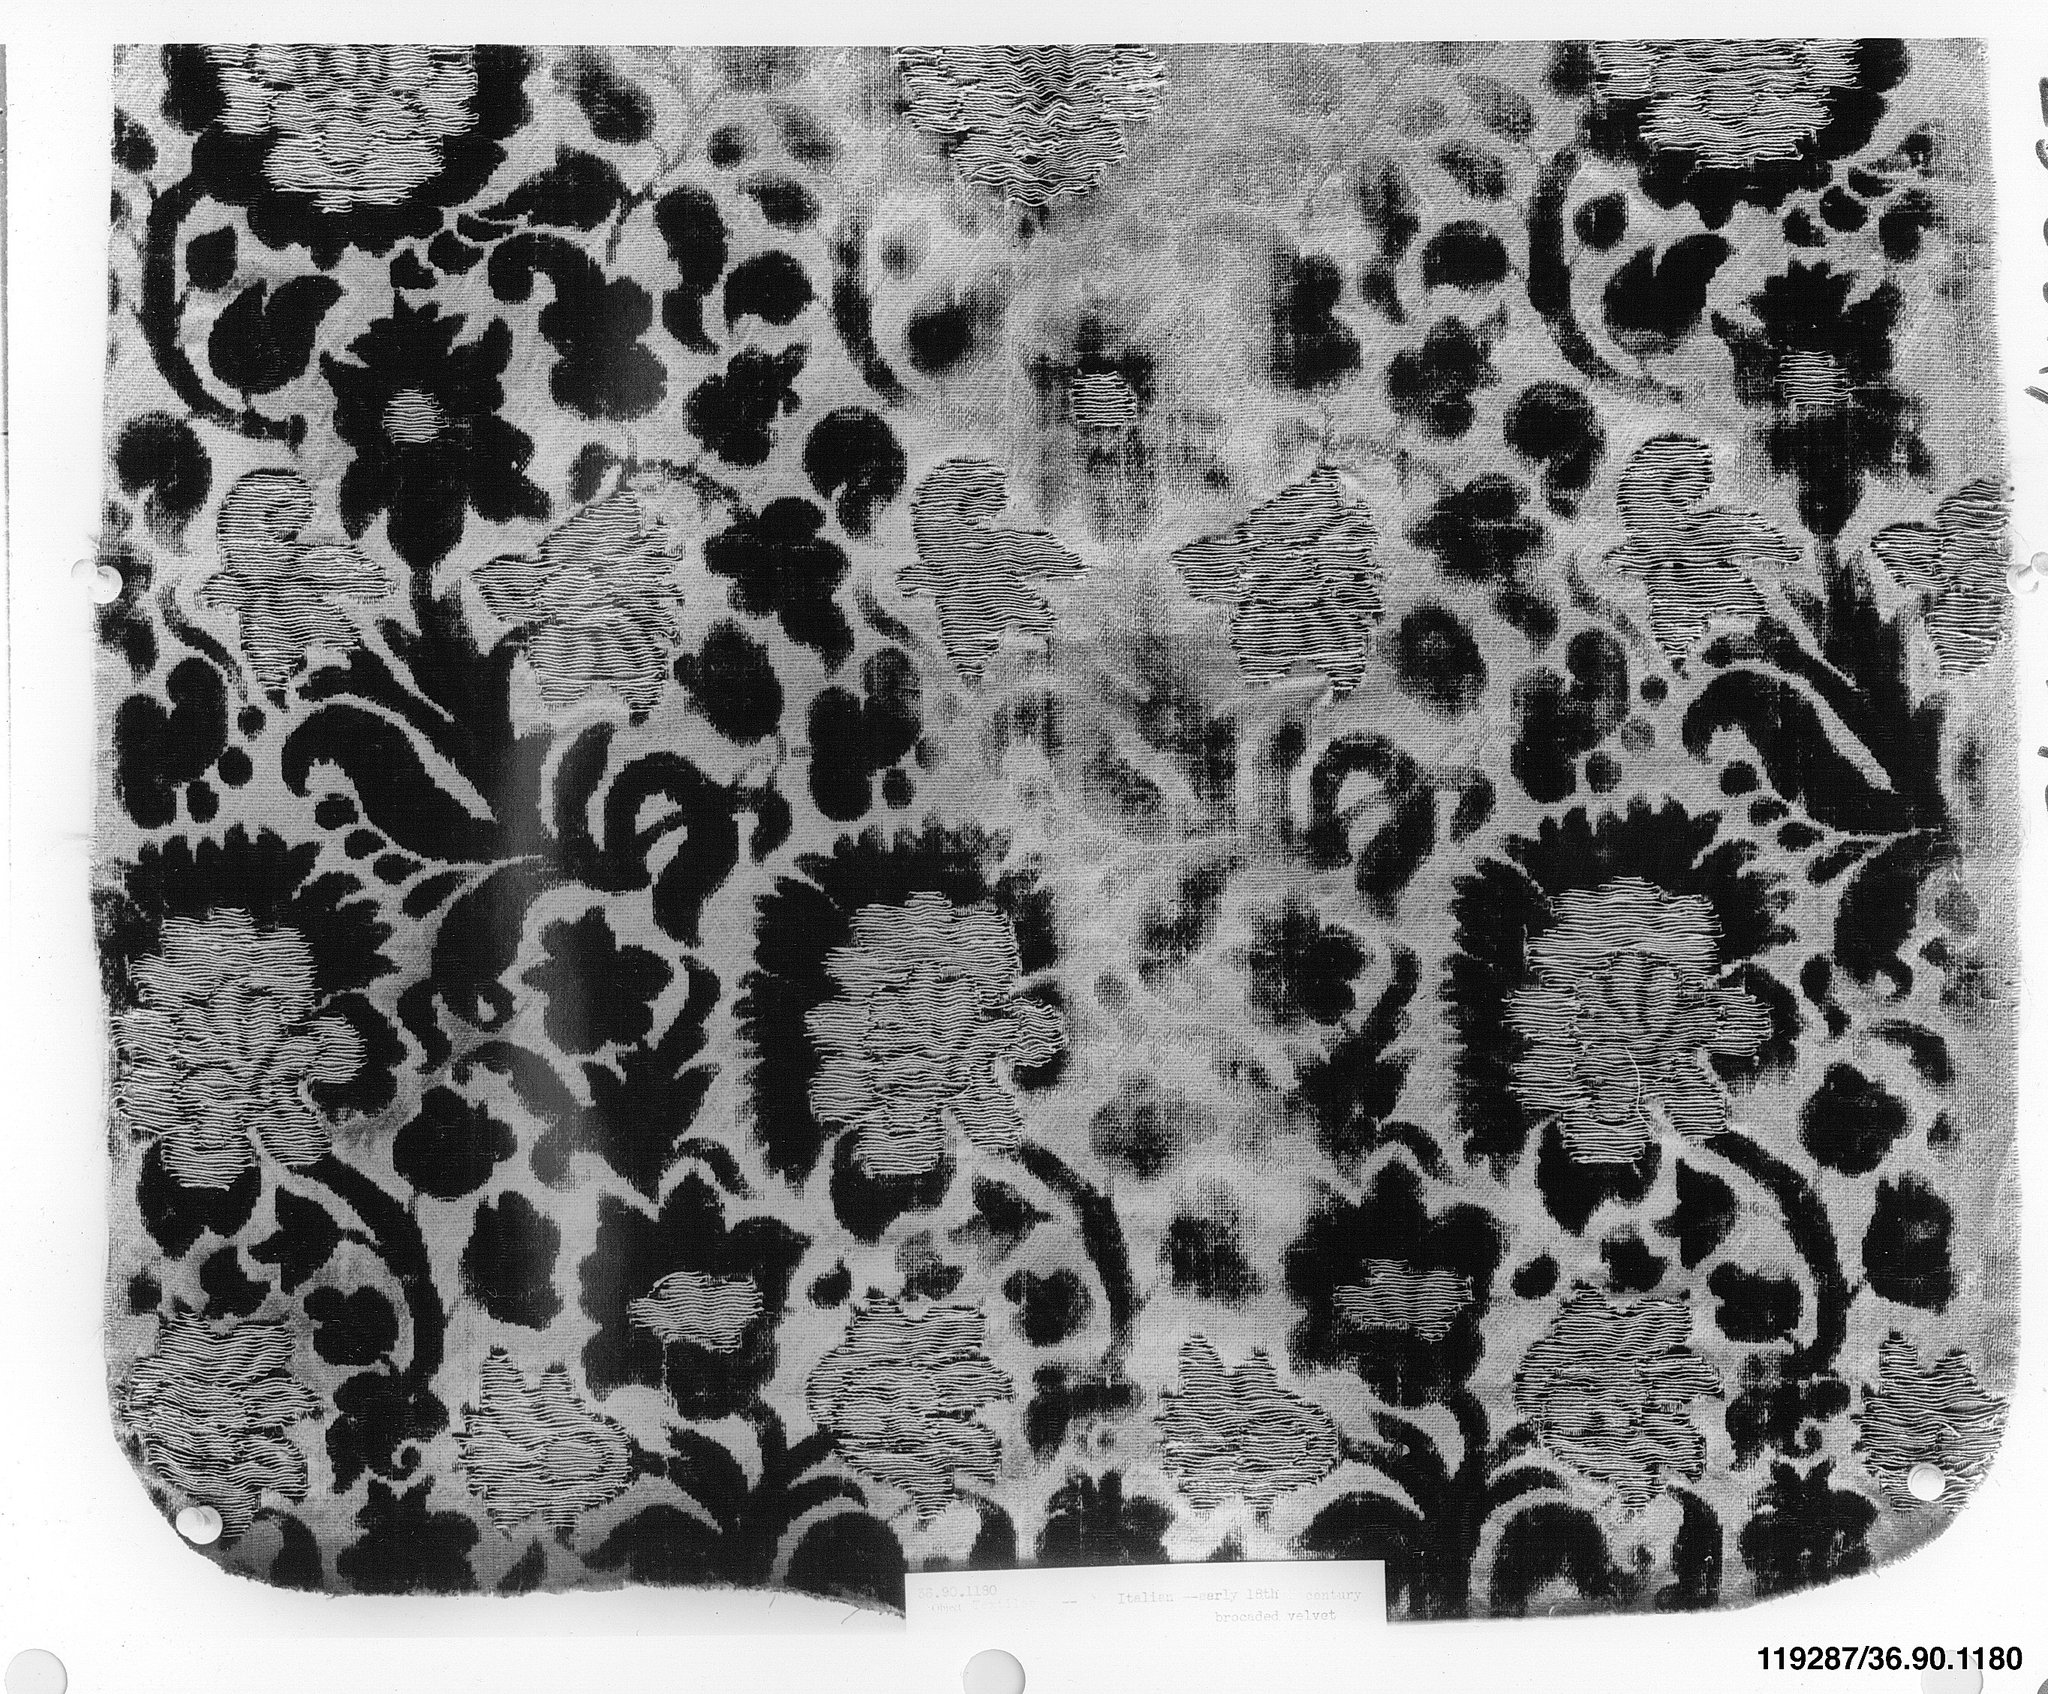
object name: piece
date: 1701-1733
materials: metal thread, silk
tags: flowers,leaves